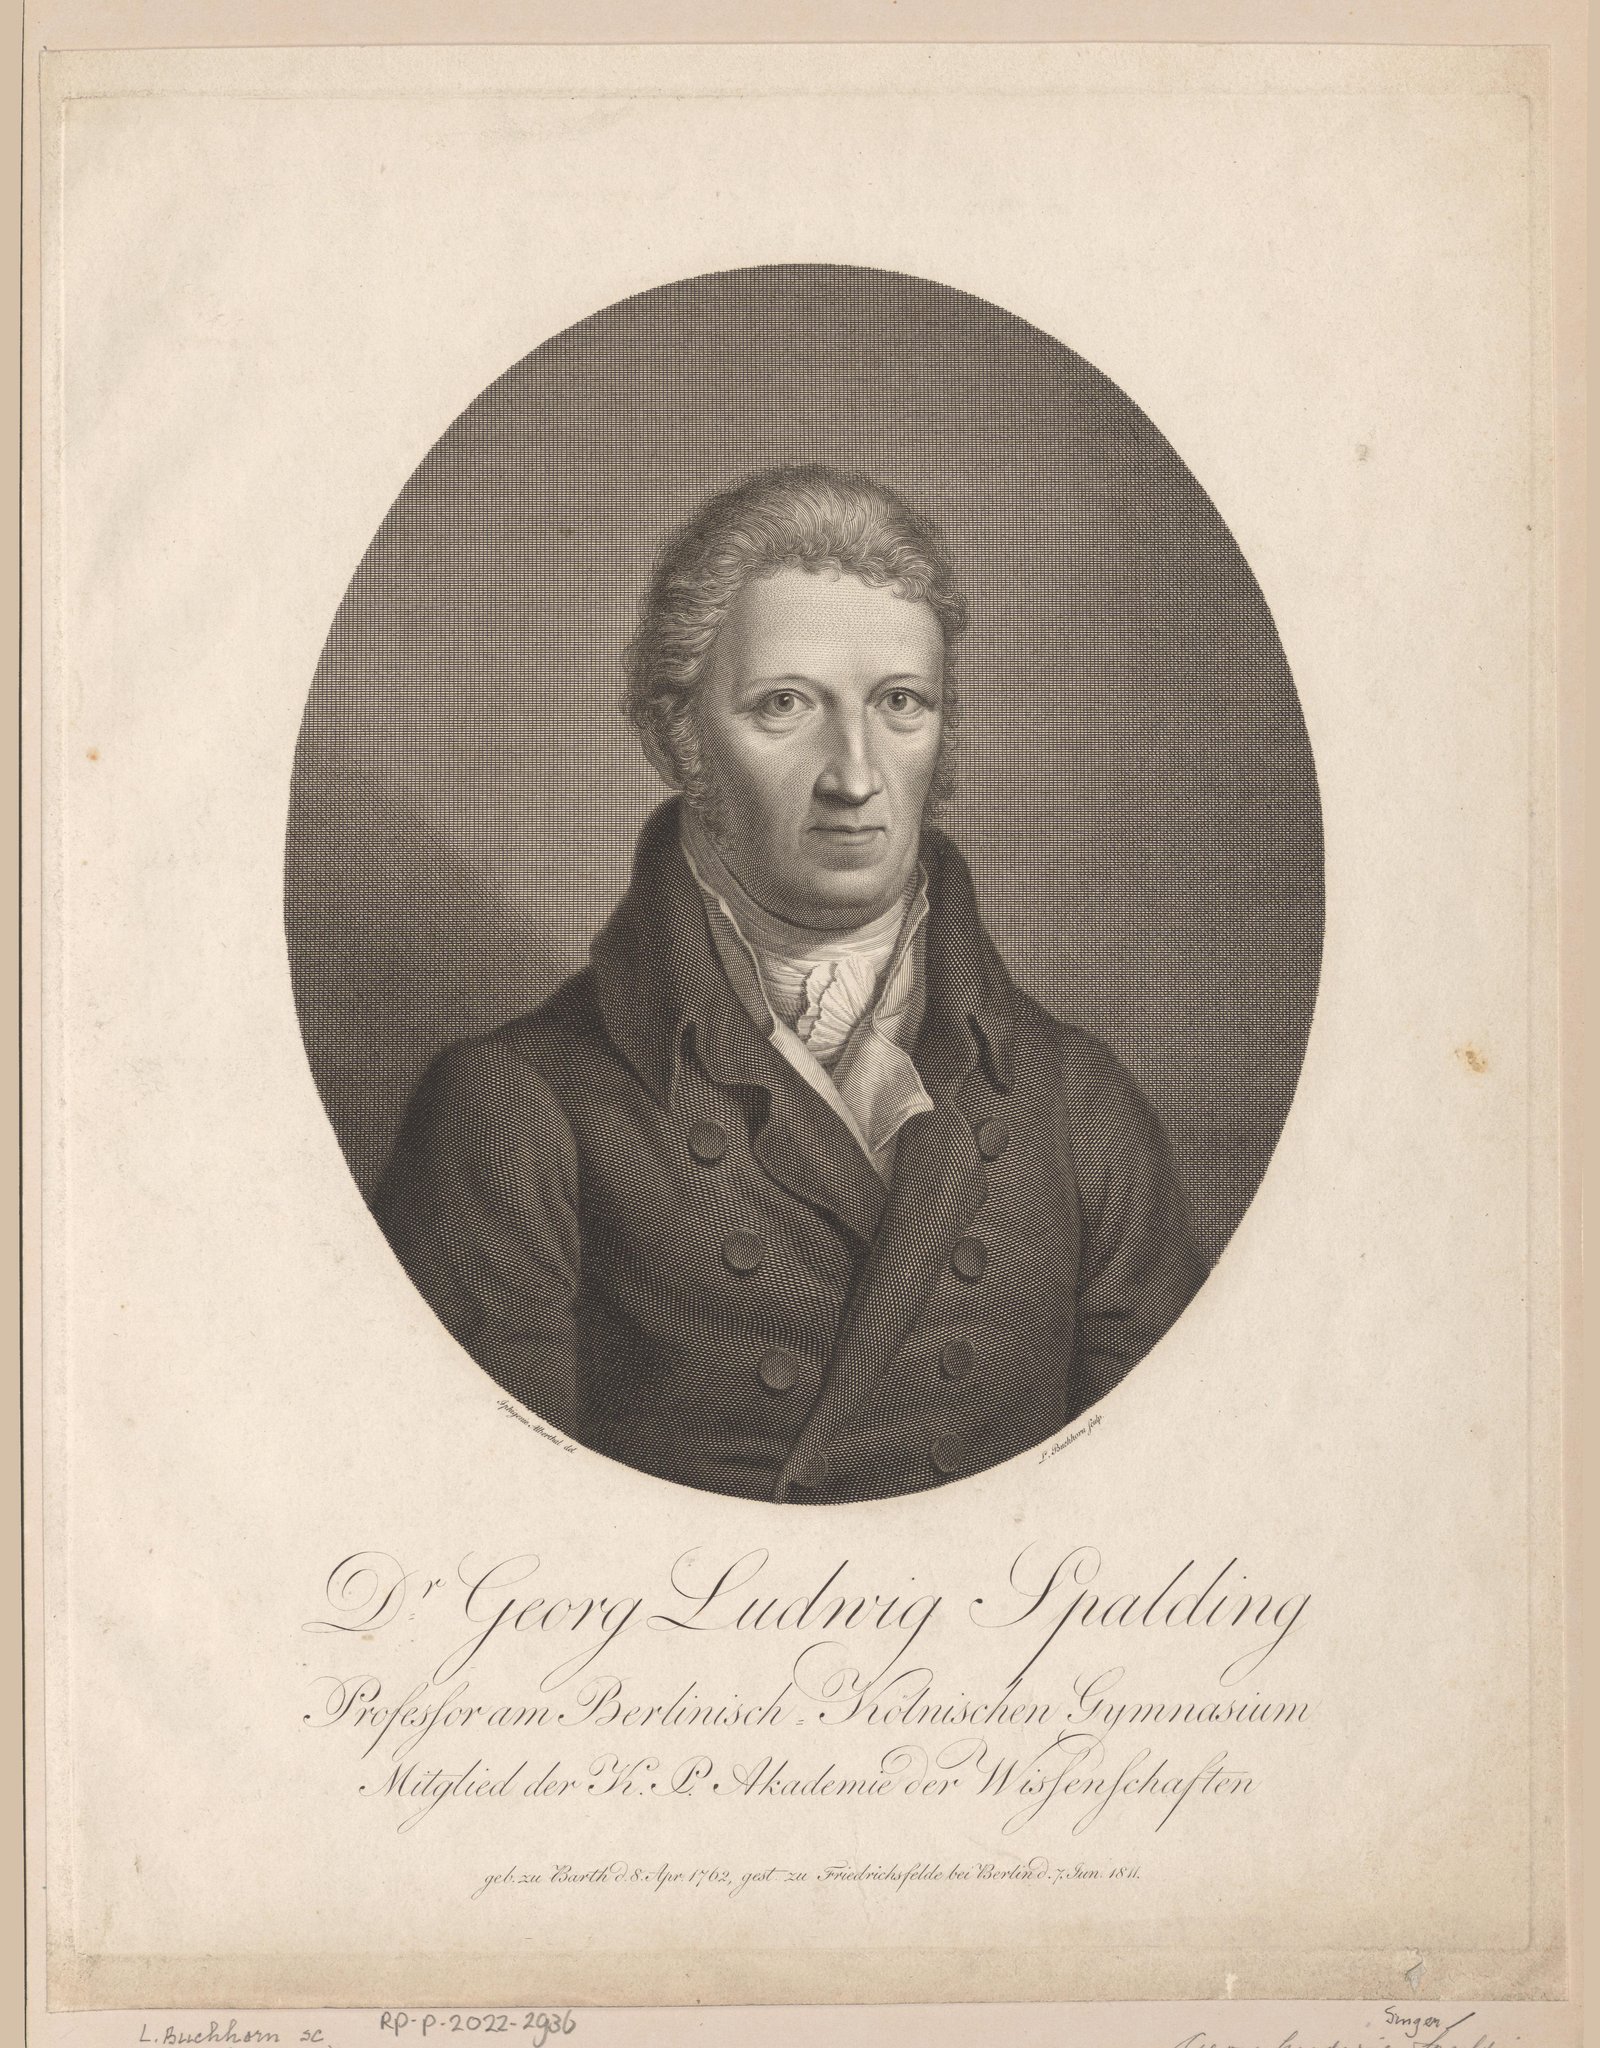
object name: print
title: Portret van Georg Ludwig Spalding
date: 1811-1856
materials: paper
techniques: engraving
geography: berlin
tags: philology (+ portrait of scholar, scientist), historical persons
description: Met drieregelig onderschrift in het Duits.